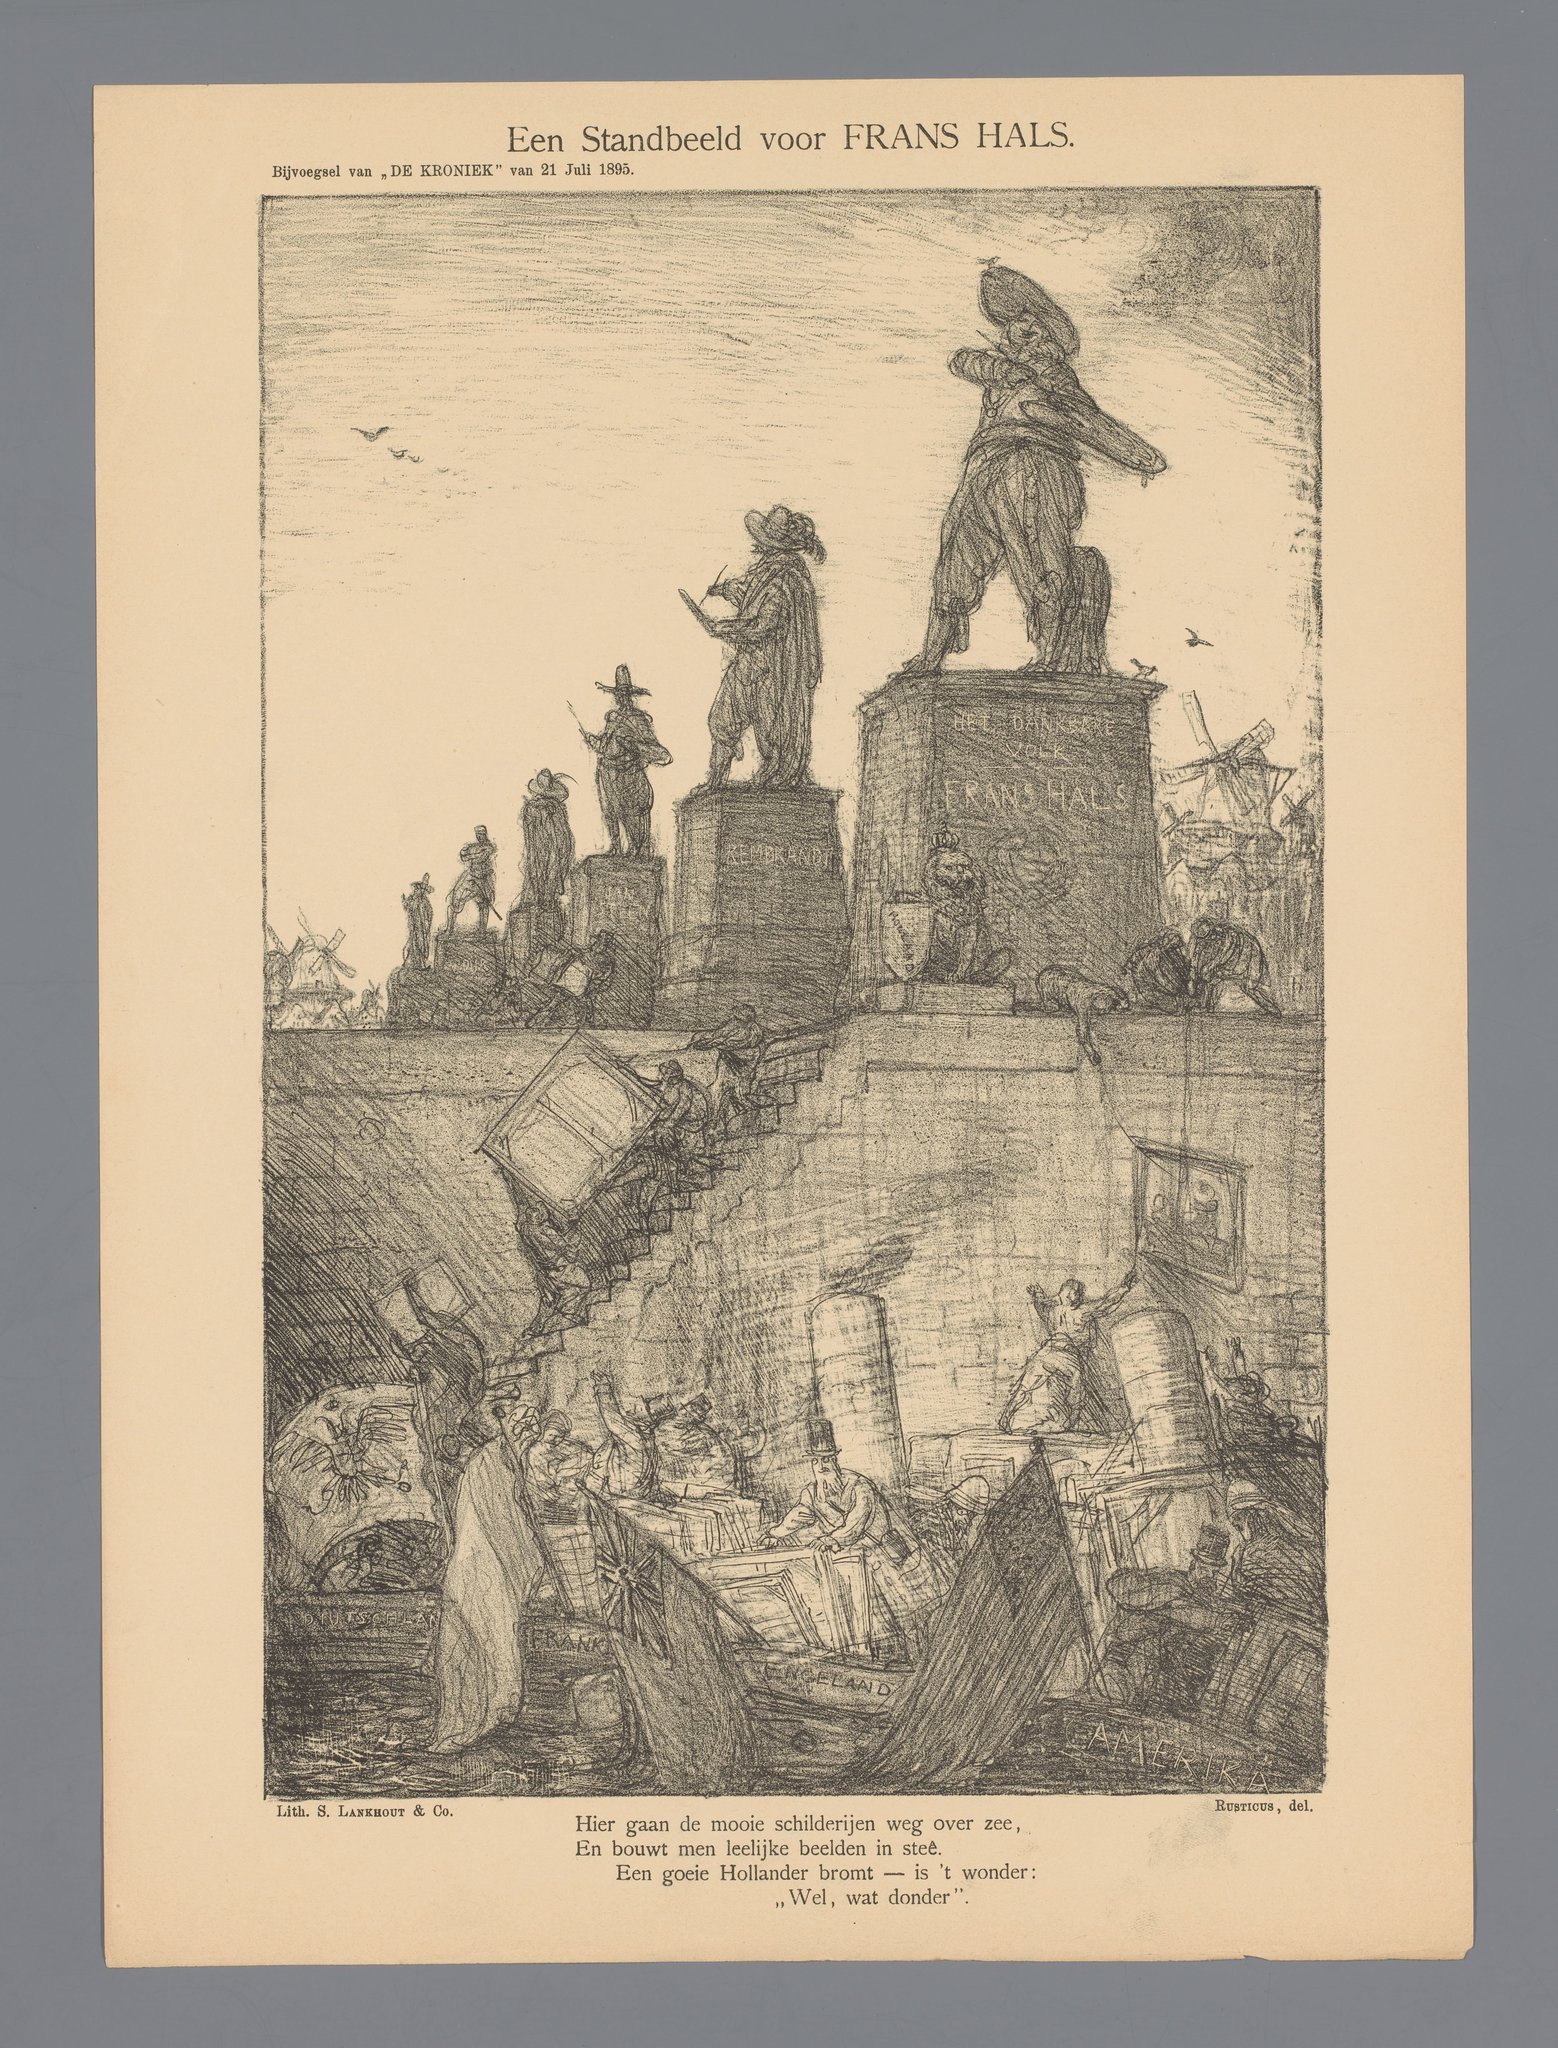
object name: cartoon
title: Een Standbeeld voor Frans Hals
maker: marius bauer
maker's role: draughtsman, print maker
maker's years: 1867-1932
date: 1895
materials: paper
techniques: lithograph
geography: the hague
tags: frans hals, leiden, painter, print maker, jan havicksz. steen, amsterdam, draughtsman, rembrandt van rijn, historical persons, monument, statue, picture, painting, political caricatures and satires, netherlands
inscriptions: date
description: Een standbeeld van Frans Hals is opgericht in een rij met beelden van Rembrandt, Jan Steen en andere kunstenaars. Op de voorgrond worden schilderijen in boten afgevoerd naar het buitenland. Spotprent op het oprichten van standbeelden voor kunstenaars, terwijl ondertussen hun werk naar het buitenland wordt verscheept.